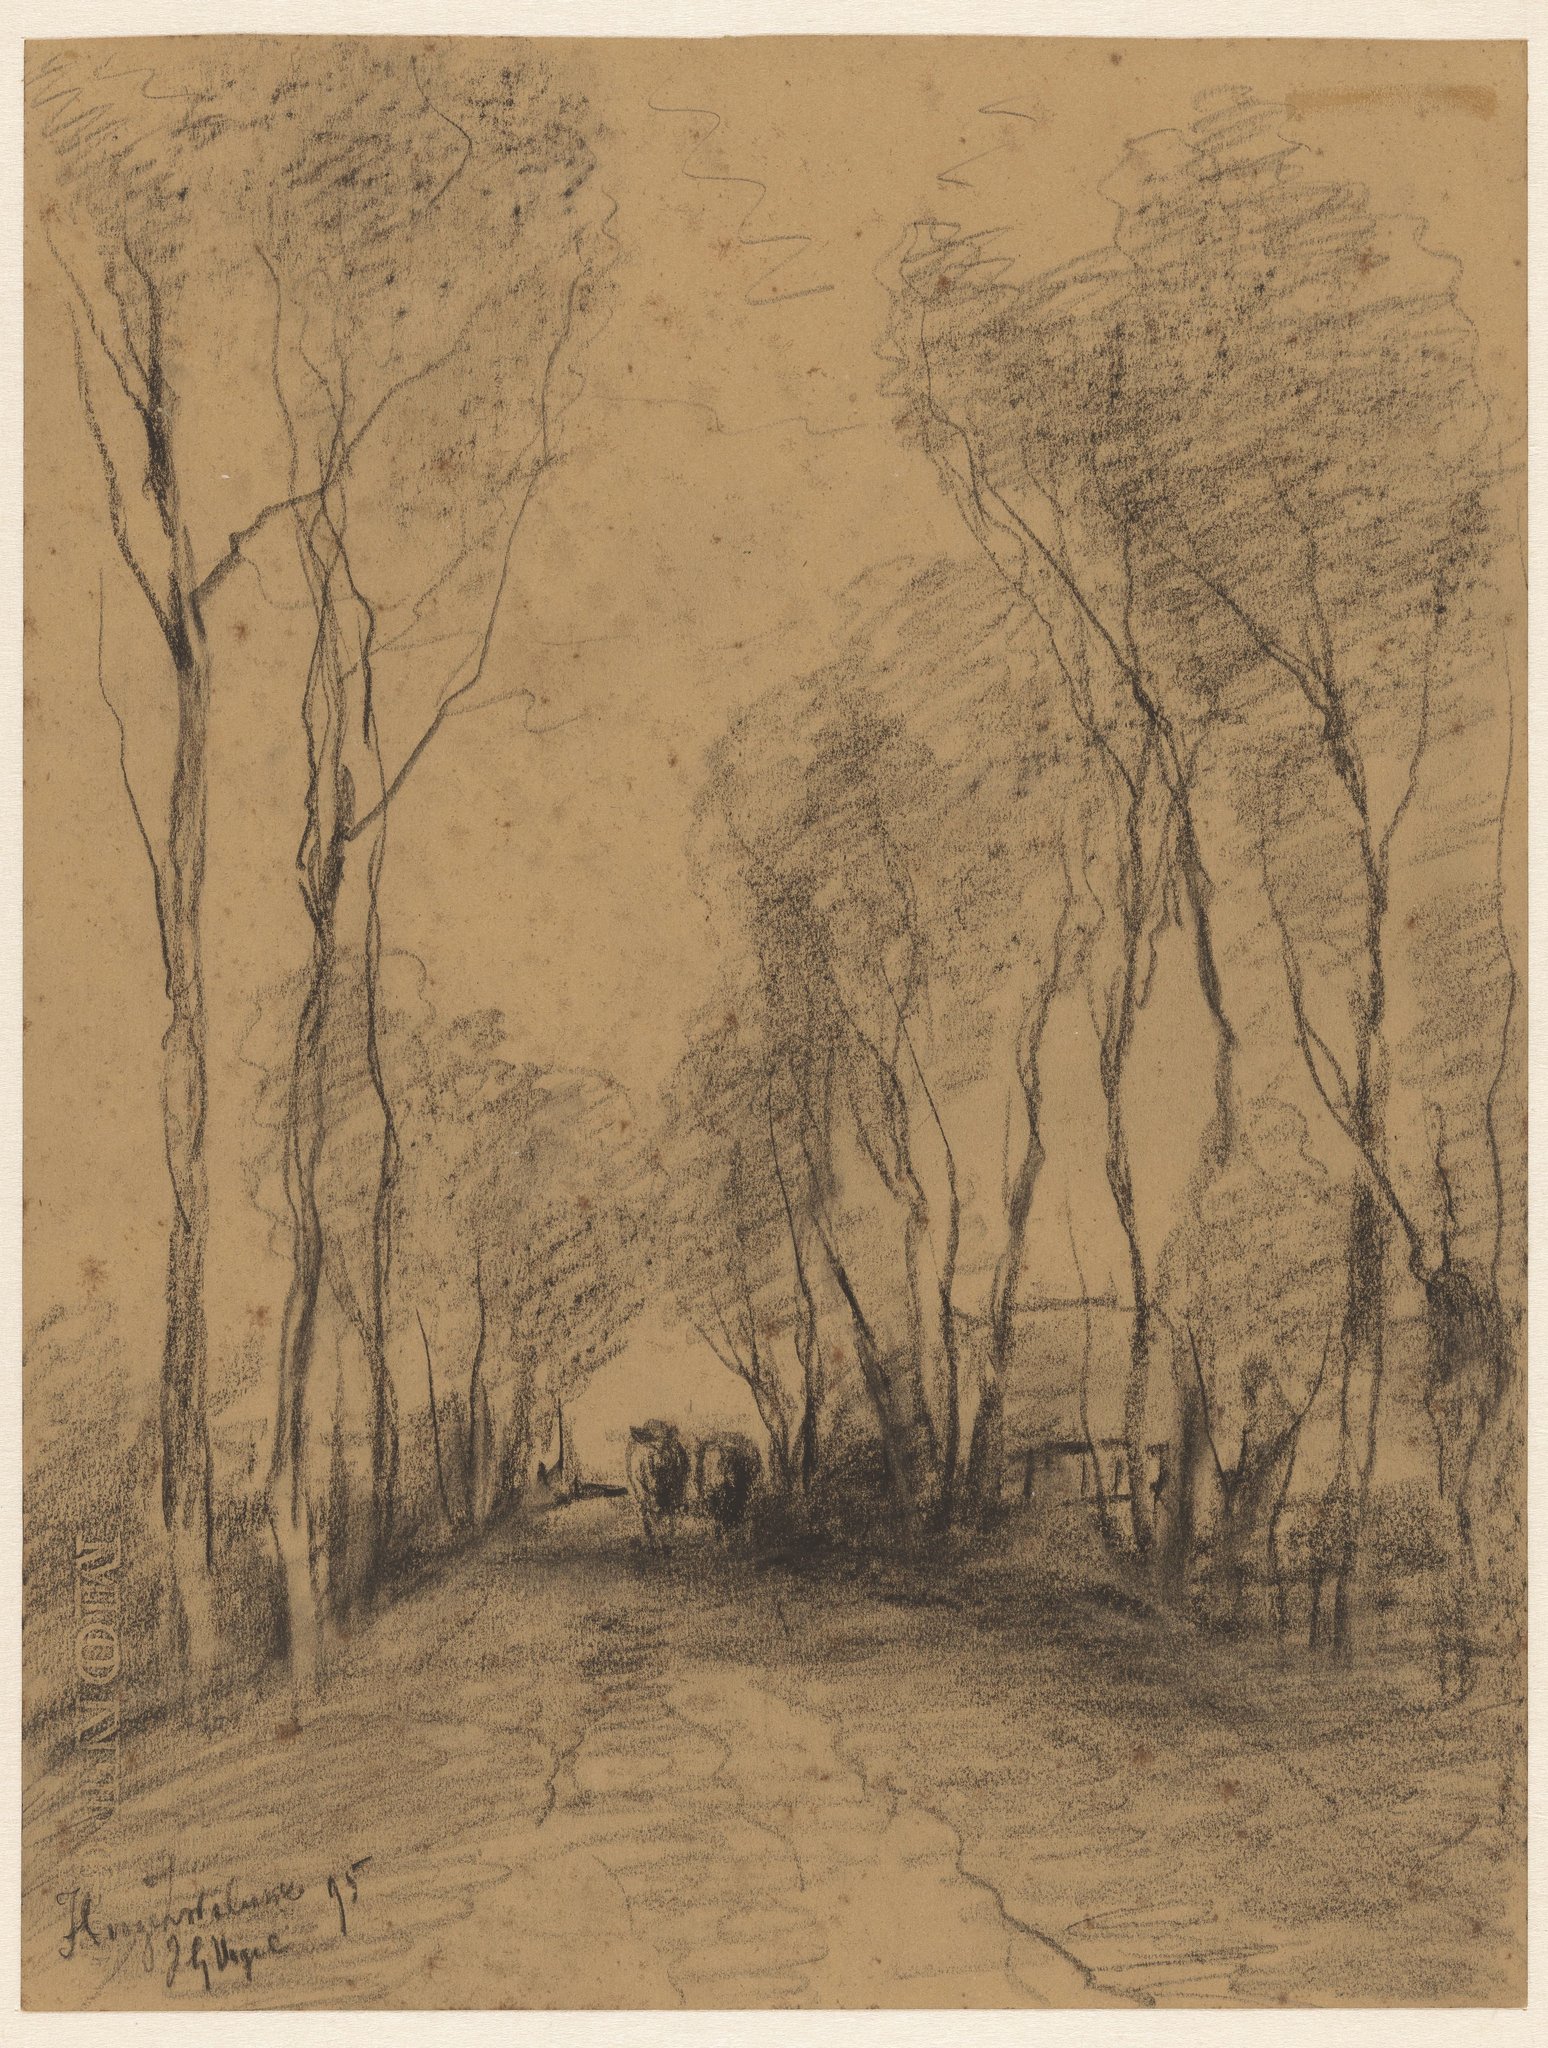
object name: drawing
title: Landweg met koeien bij Hoge Zwaluwe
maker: johannes gijsbert vogel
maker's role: draughtsman, painter, print maker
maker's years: 1828-1915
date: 1895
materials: chalk, paper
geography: hooge zwaluwe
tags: forest, wood, bovine cattle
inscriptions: date